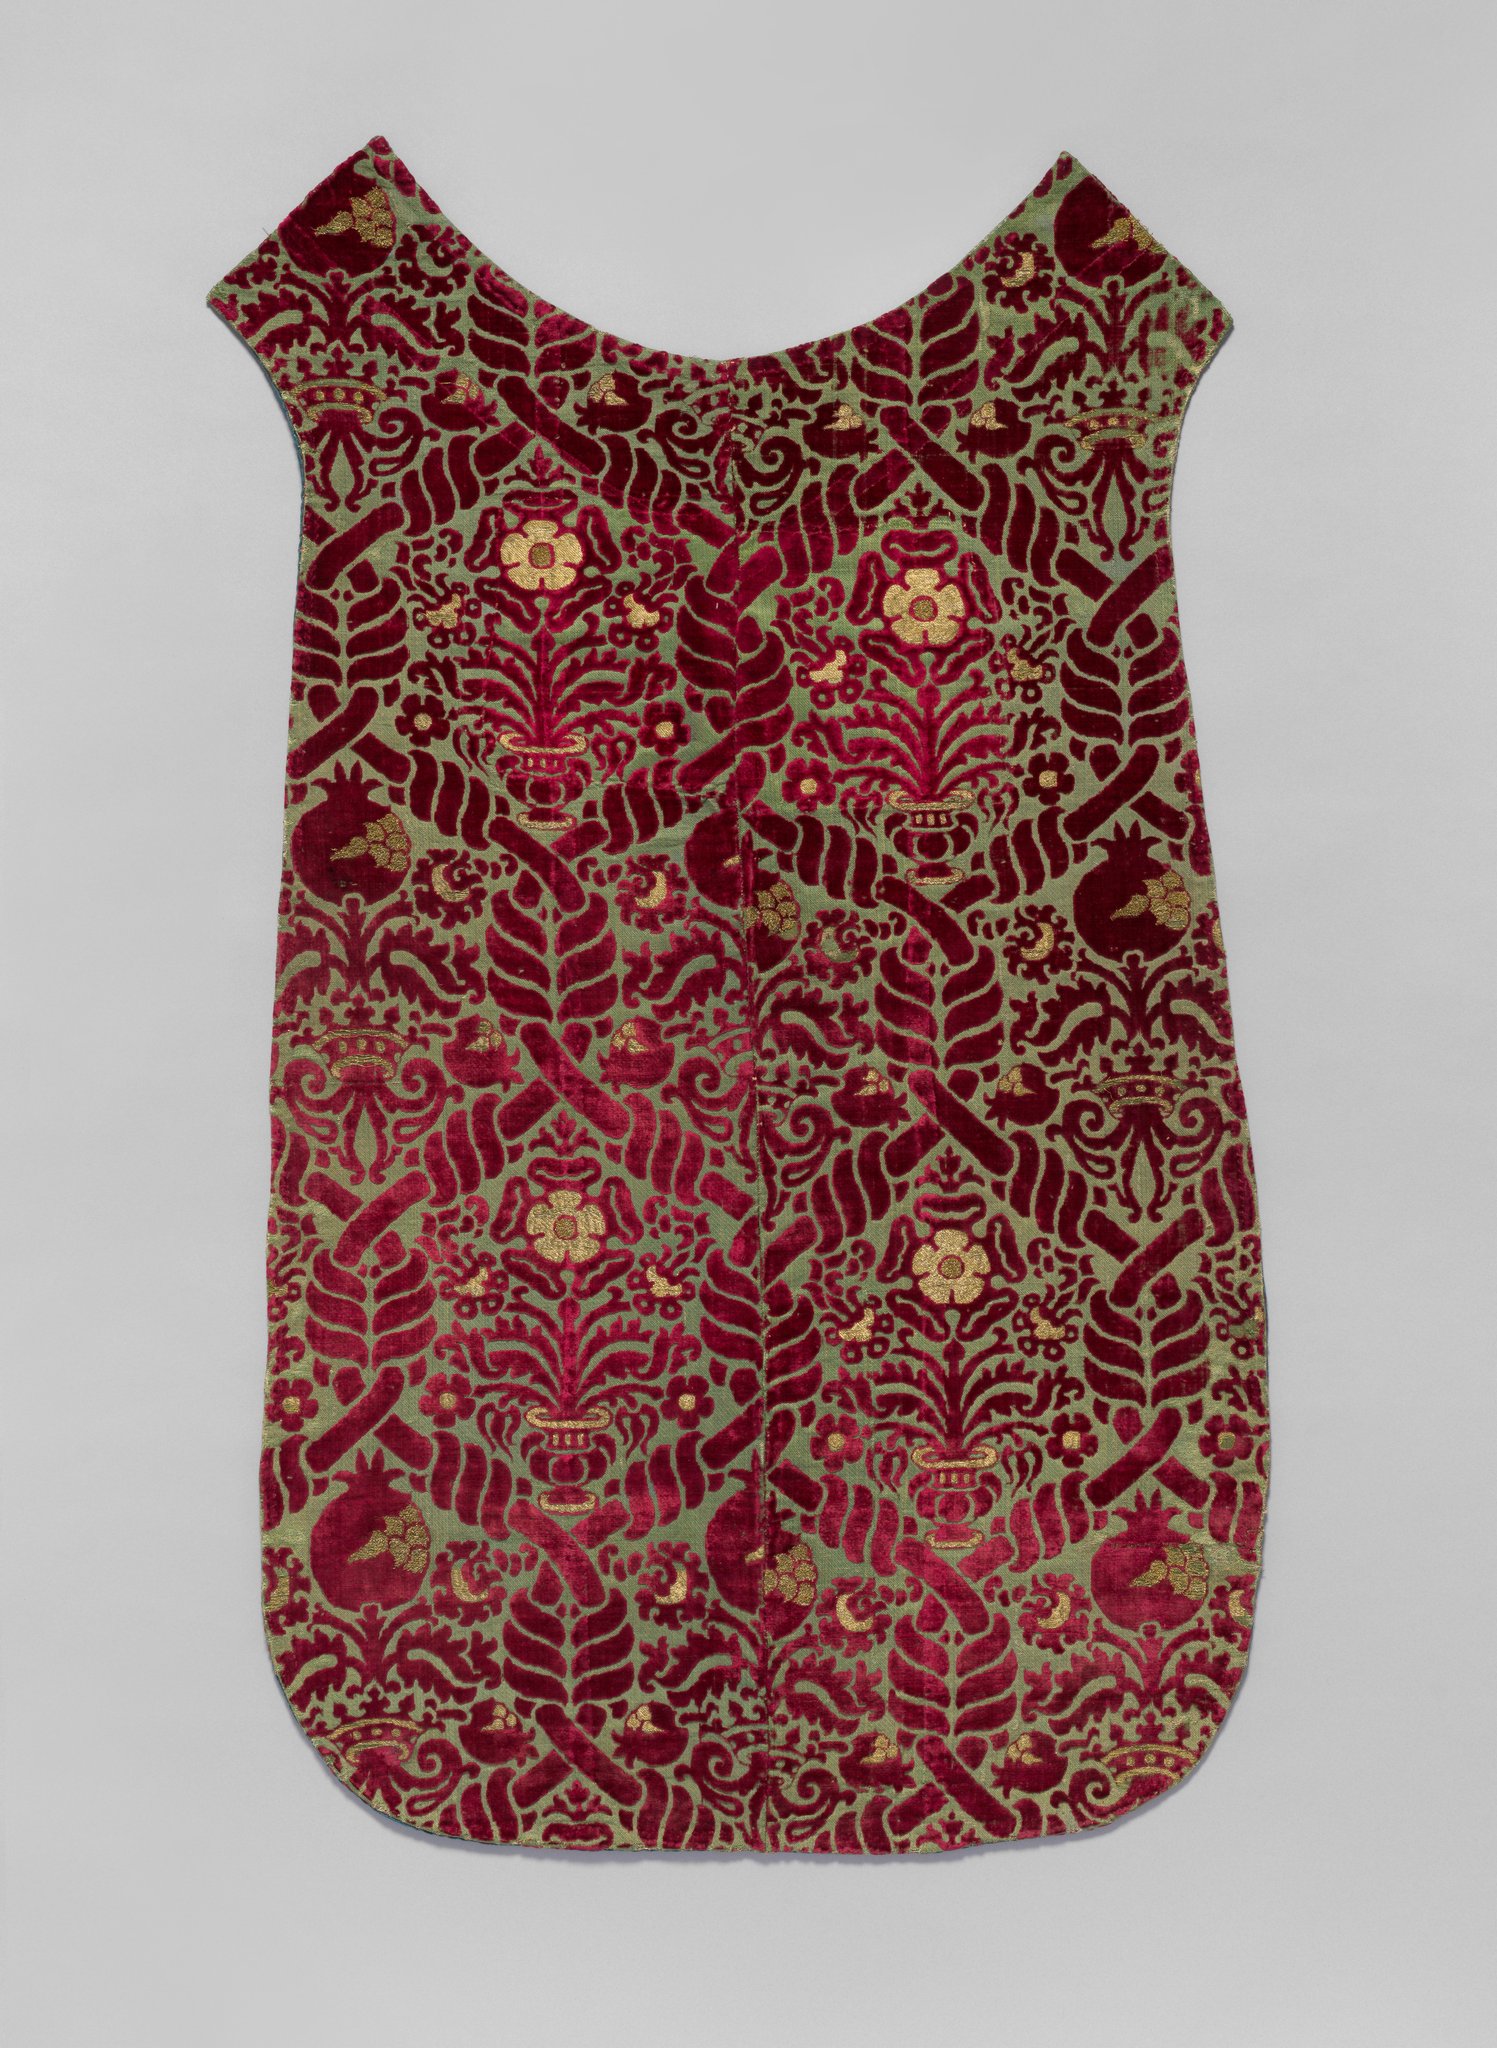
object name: chasuble back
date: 1467-1500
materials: metal thread, silk